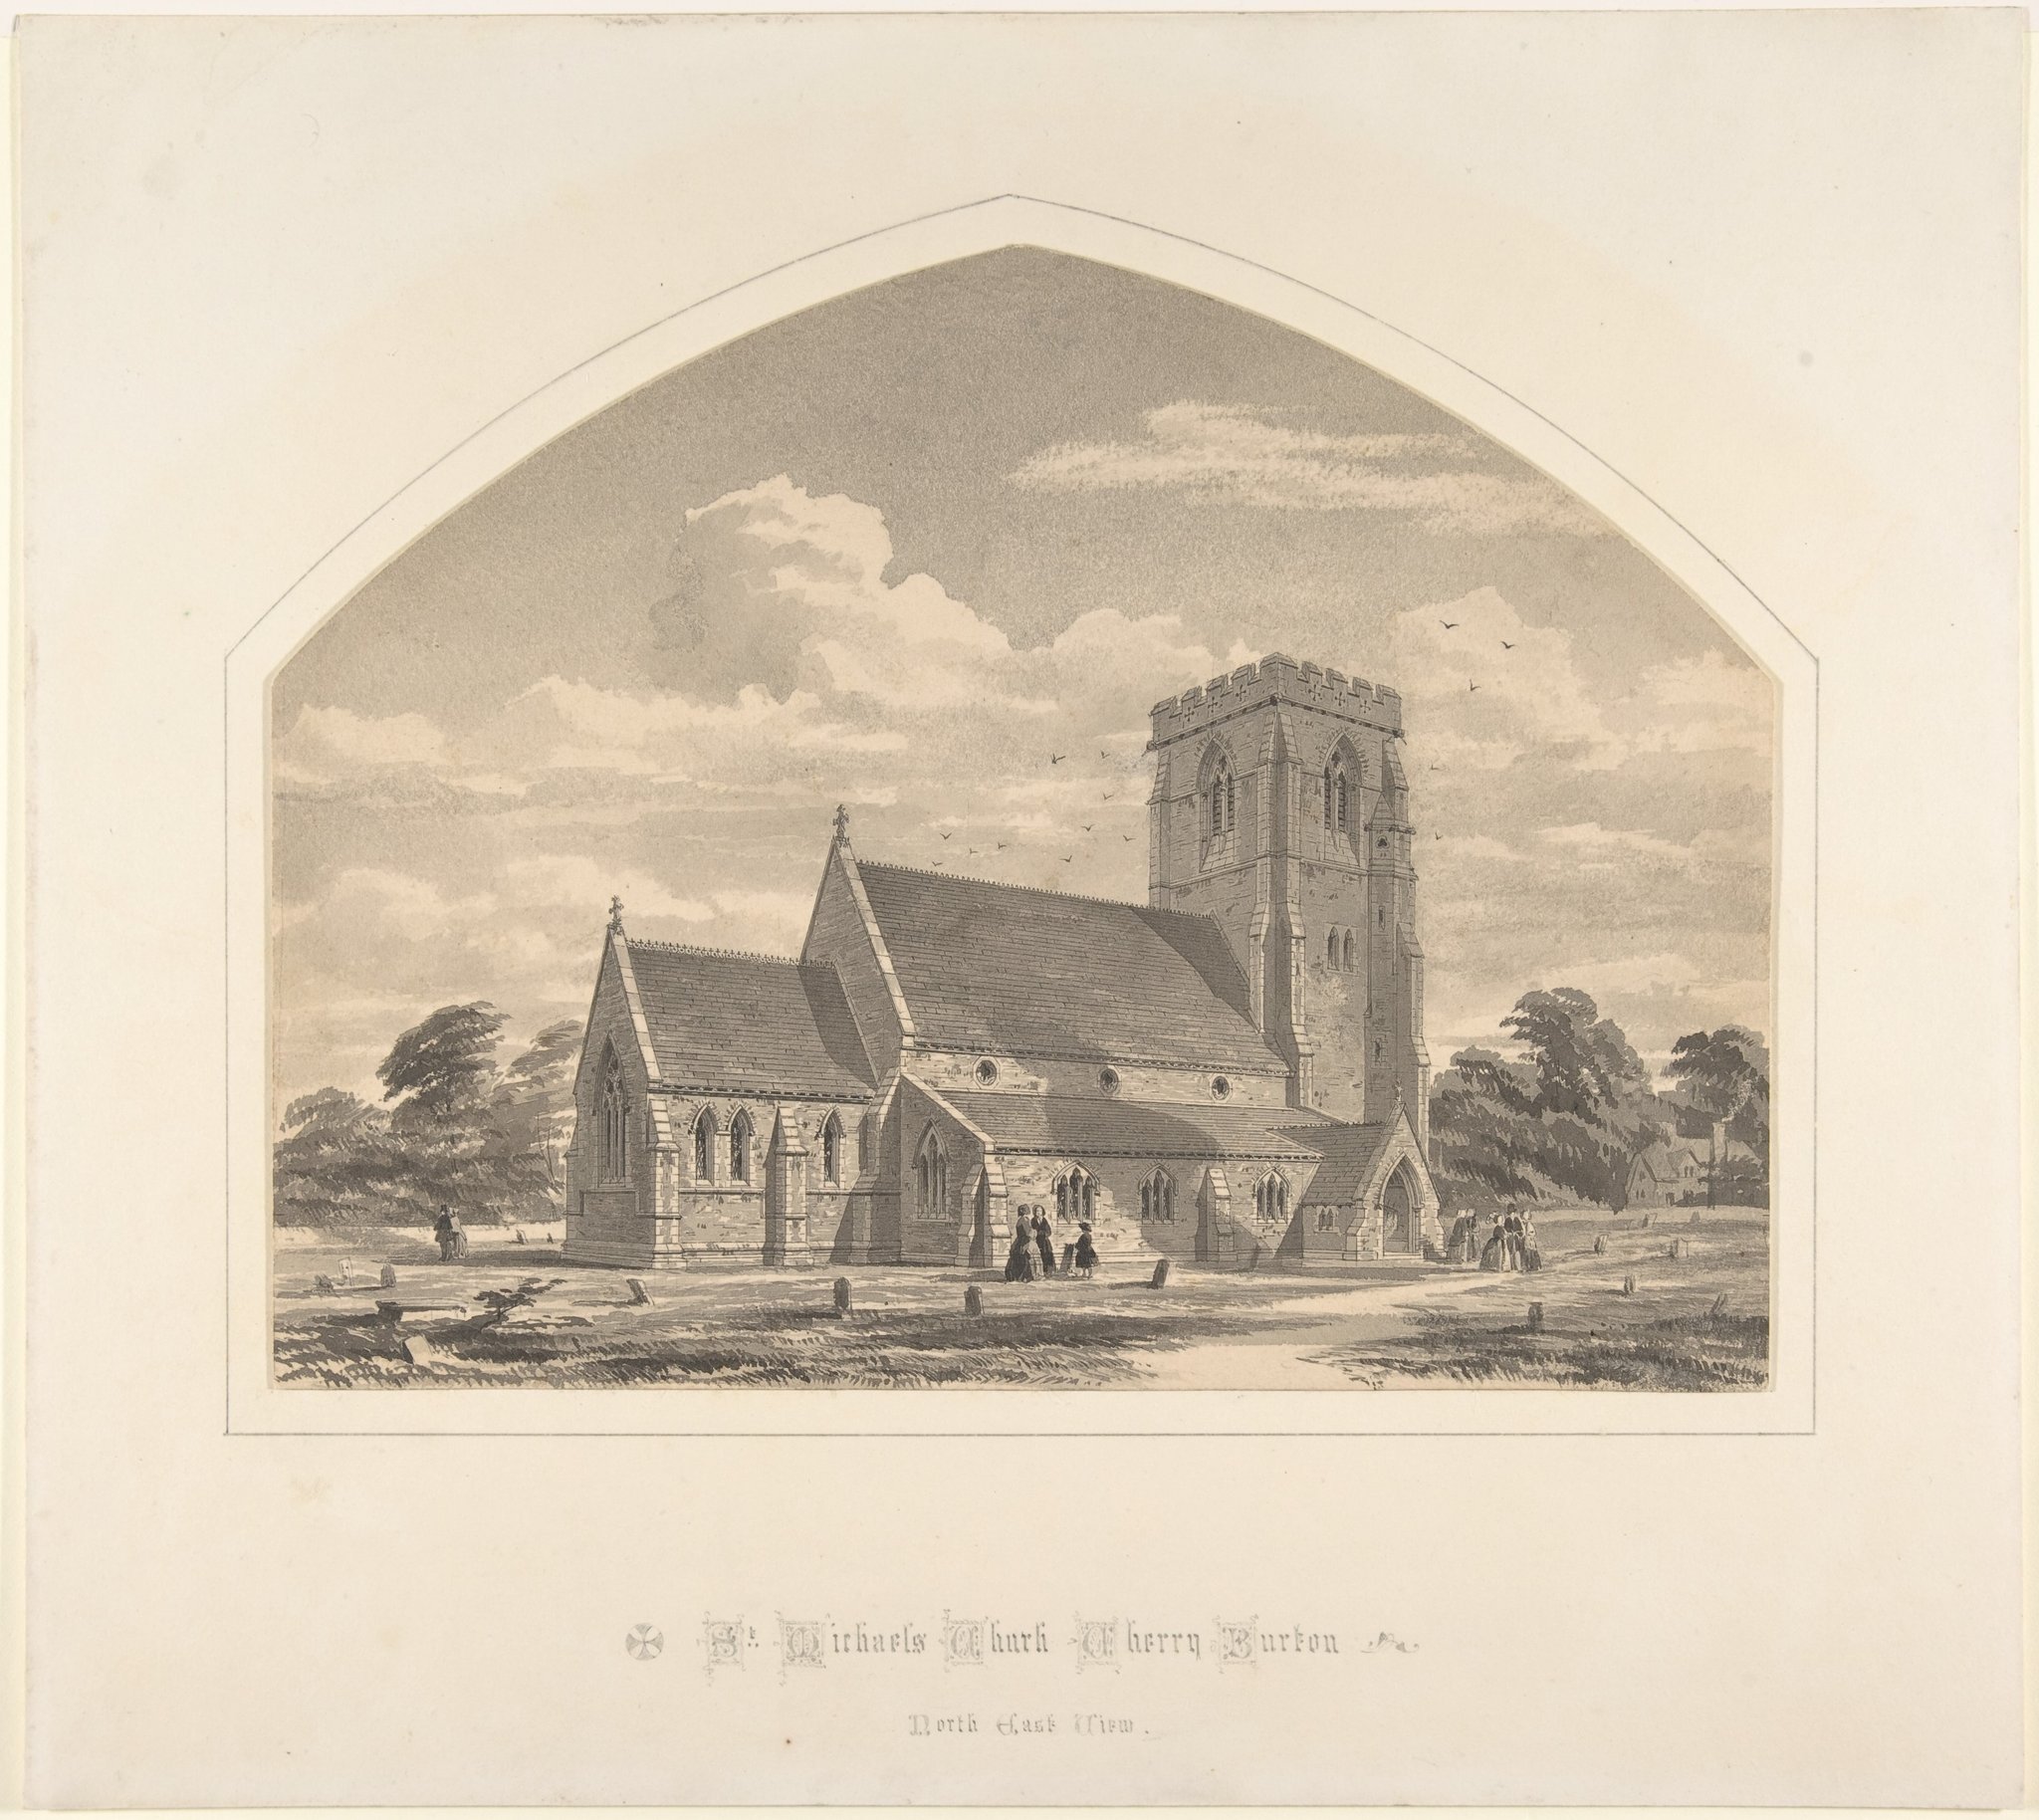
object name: drawing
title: St. Michael's Church, Cherry Burton: North East View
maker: sir horace jones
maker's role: artist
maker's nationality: british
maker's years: 1819-1887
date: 1845-1850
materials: graphite, ink, watercolor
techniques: pen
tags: human figures,churches